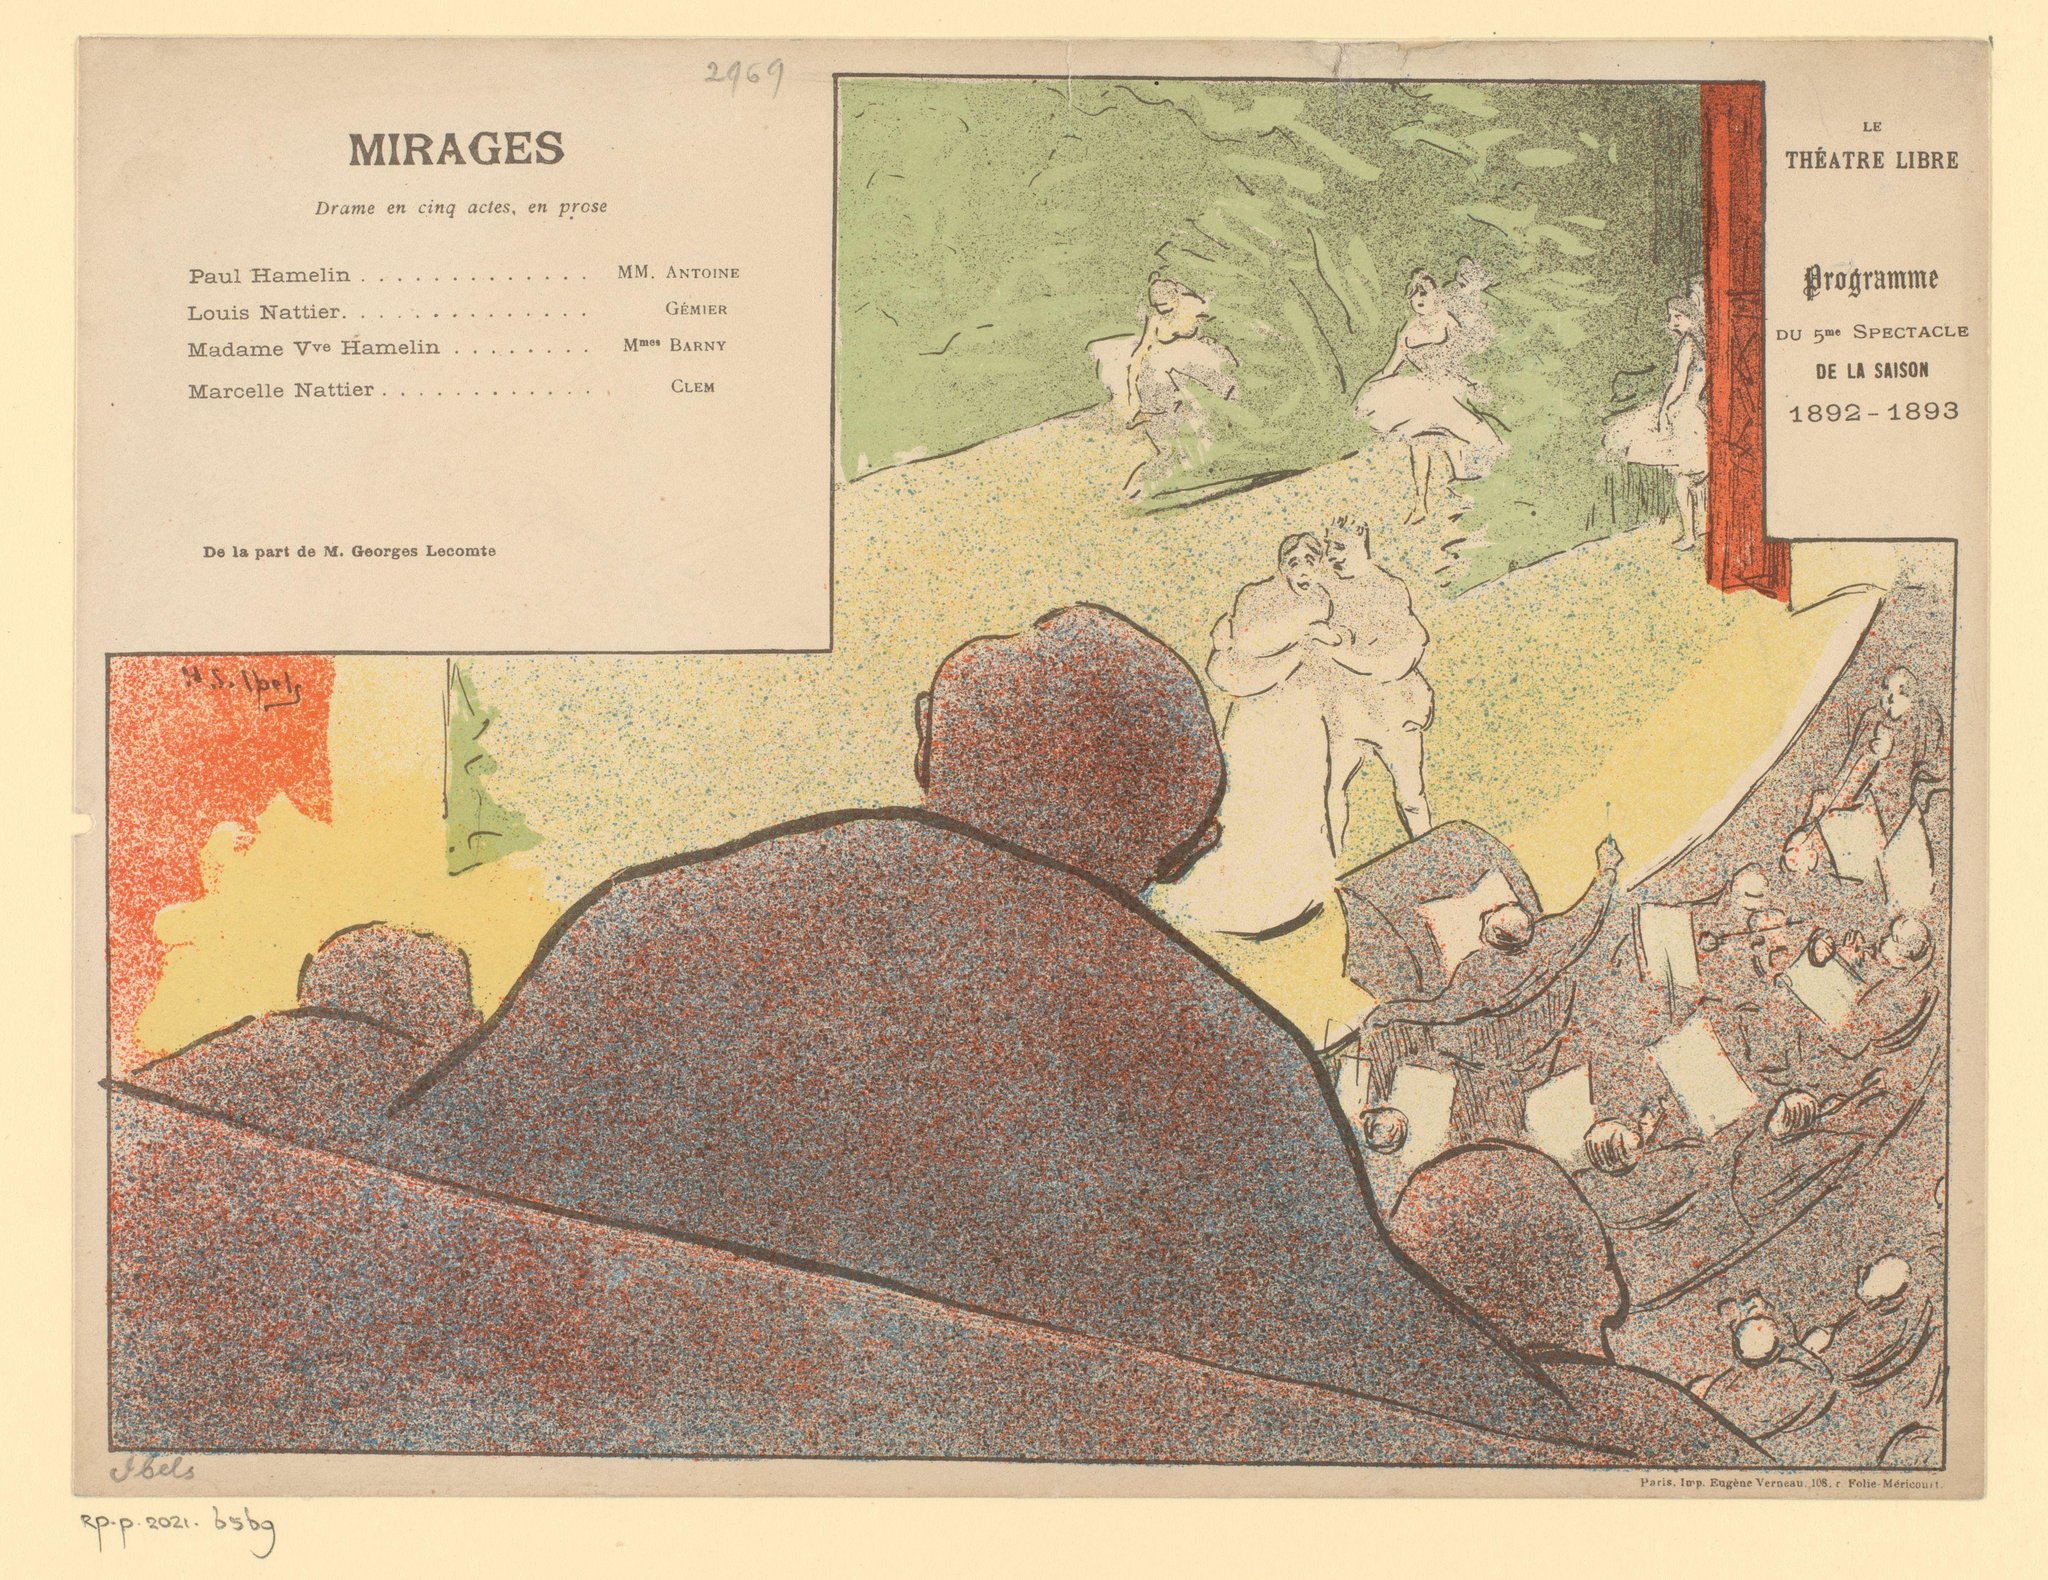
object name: programma, programmaboekje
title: Programma voor toneelvoorstelling 'Mirages, drame en cinq actes, en prose' bij het Théâtre Libre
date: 1892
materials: paper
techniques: lithograph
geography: paris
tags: performance, group of actors, troupe; actors on the stage, paris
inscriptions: date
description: Gezicht op toneel en orkestbak vanaf het balkon, gezien over de schouder van een toeschouwer. Linksboven de namen van de karakters en bijbehorende acteurs van de vijfde voorstelling uit het seizoen 1892-1893.